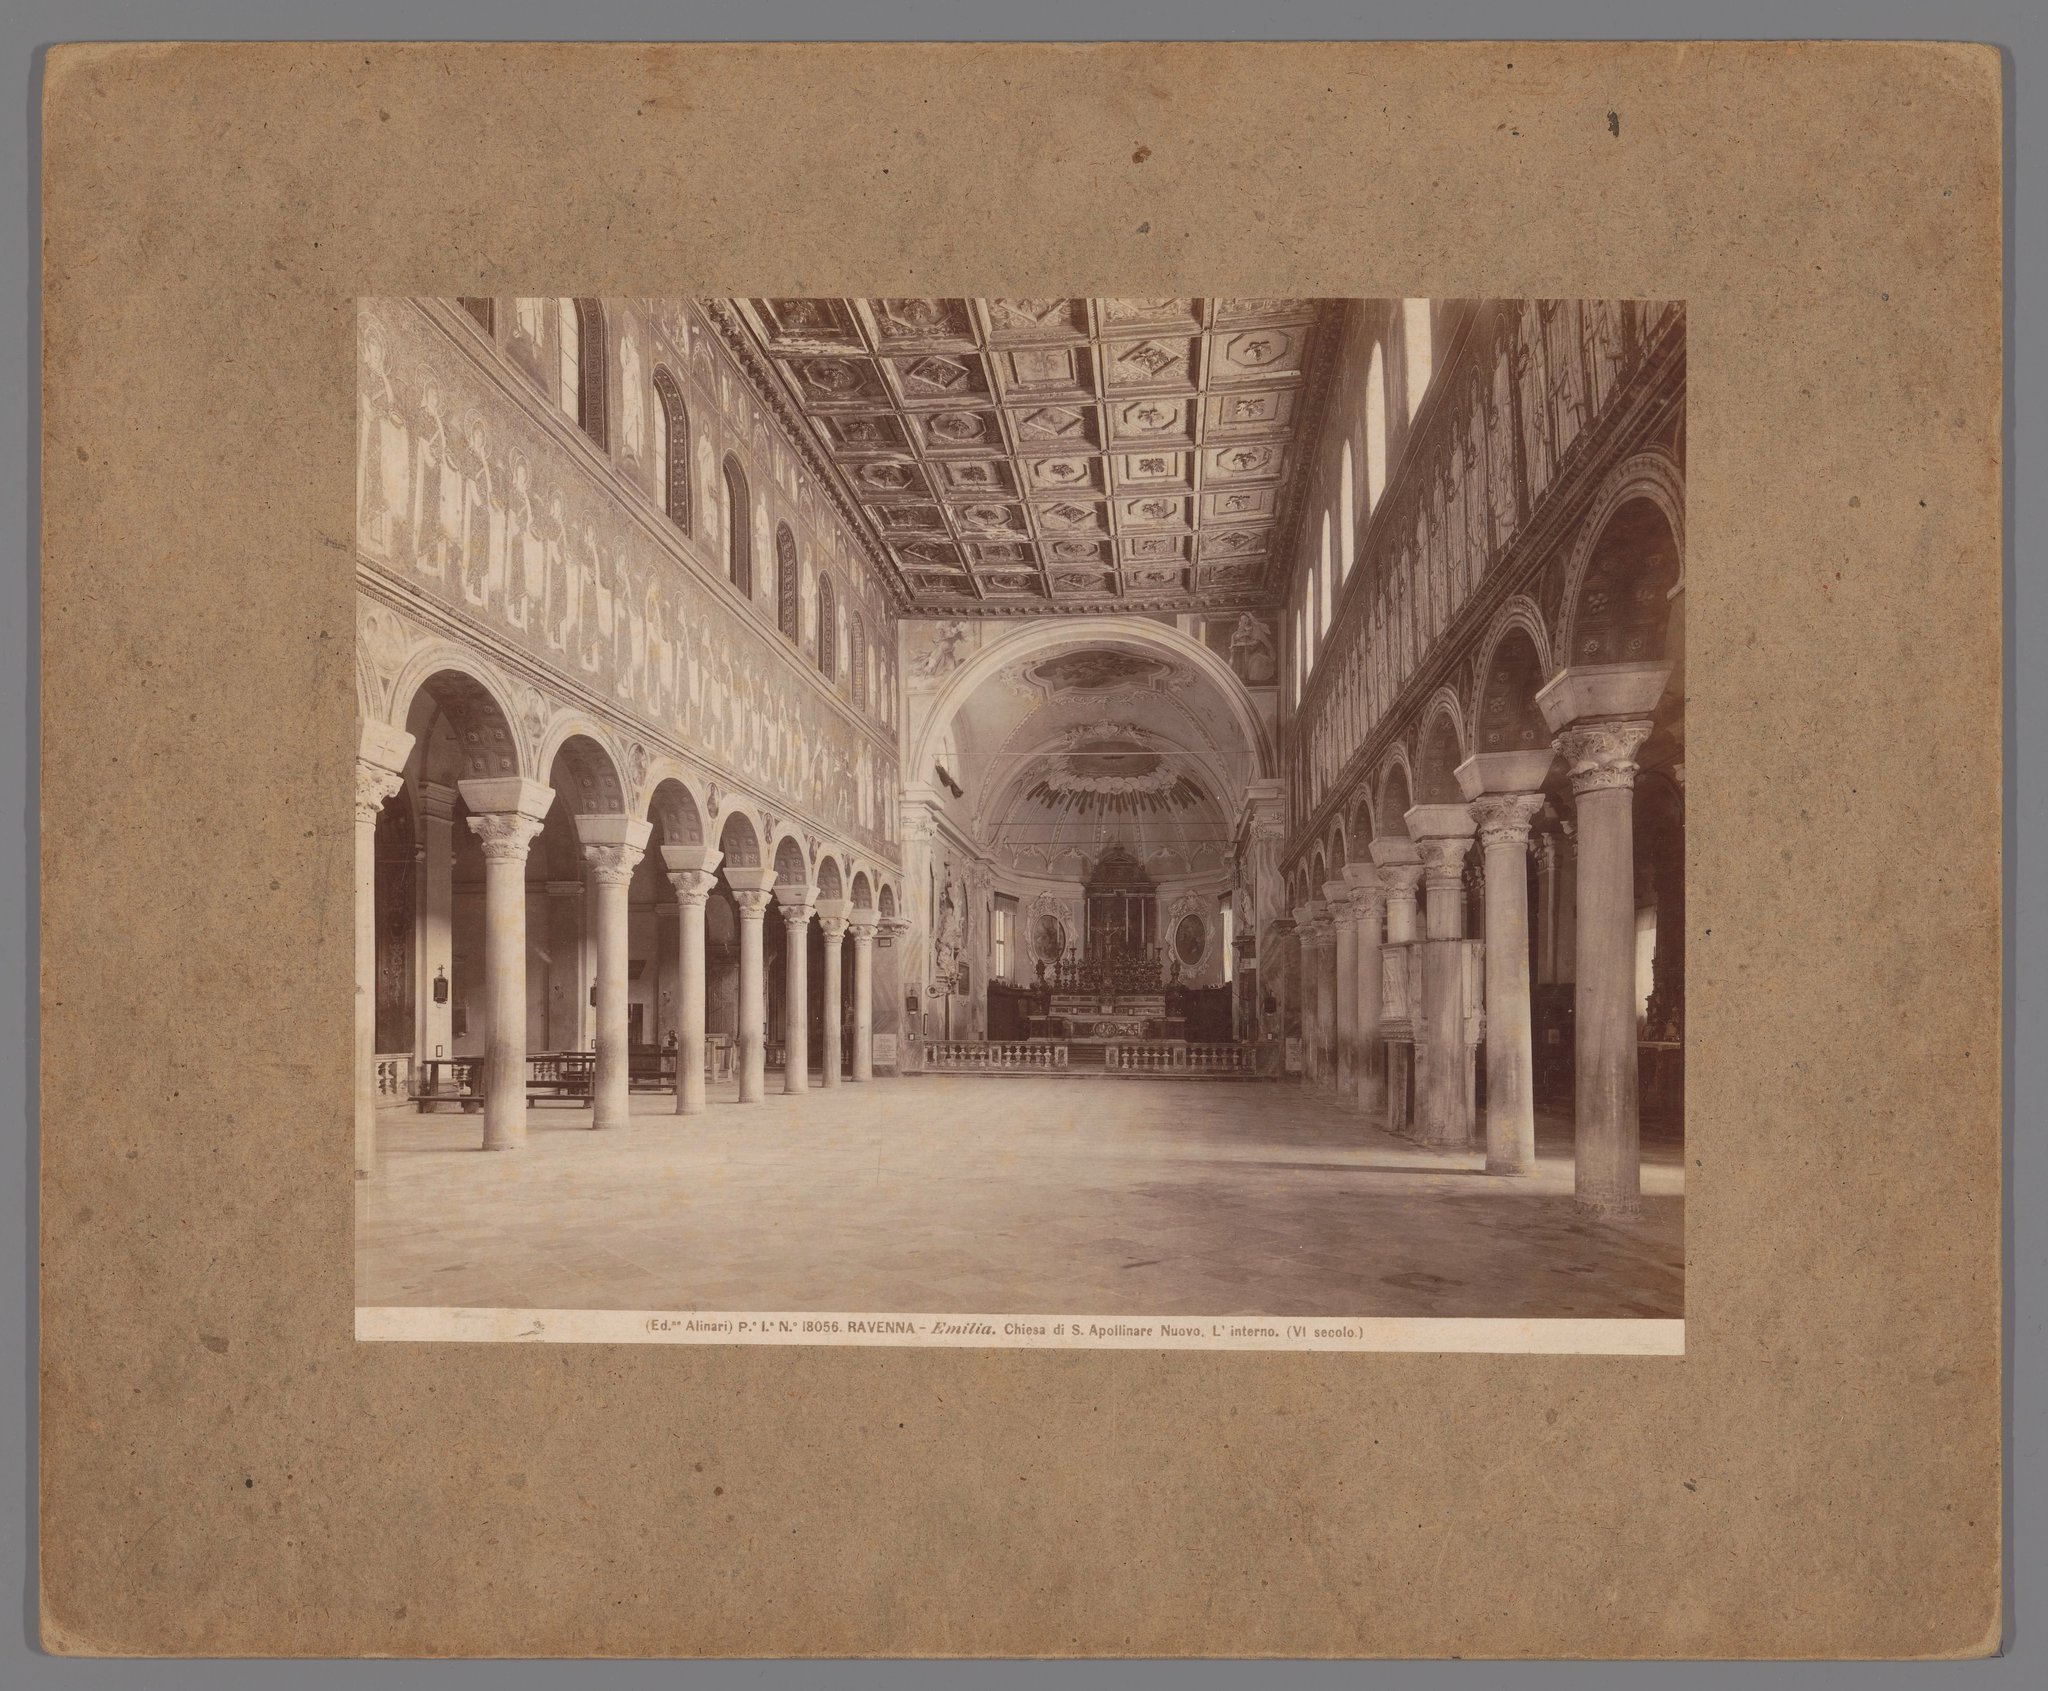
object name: photograph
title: RAVENNA - Emilia. Chiesa di S. Apollinare Nuovo. L'Interno.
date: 1875-1900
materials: cardboard, photographic support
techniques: albumen print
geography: basiliek van sant'apollinare nuovo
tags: parts of church interior: nave, parts of church interior: choir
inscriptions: collector's mark: Lugt 3937, number: ‘P.e I.a N.o 18056.’